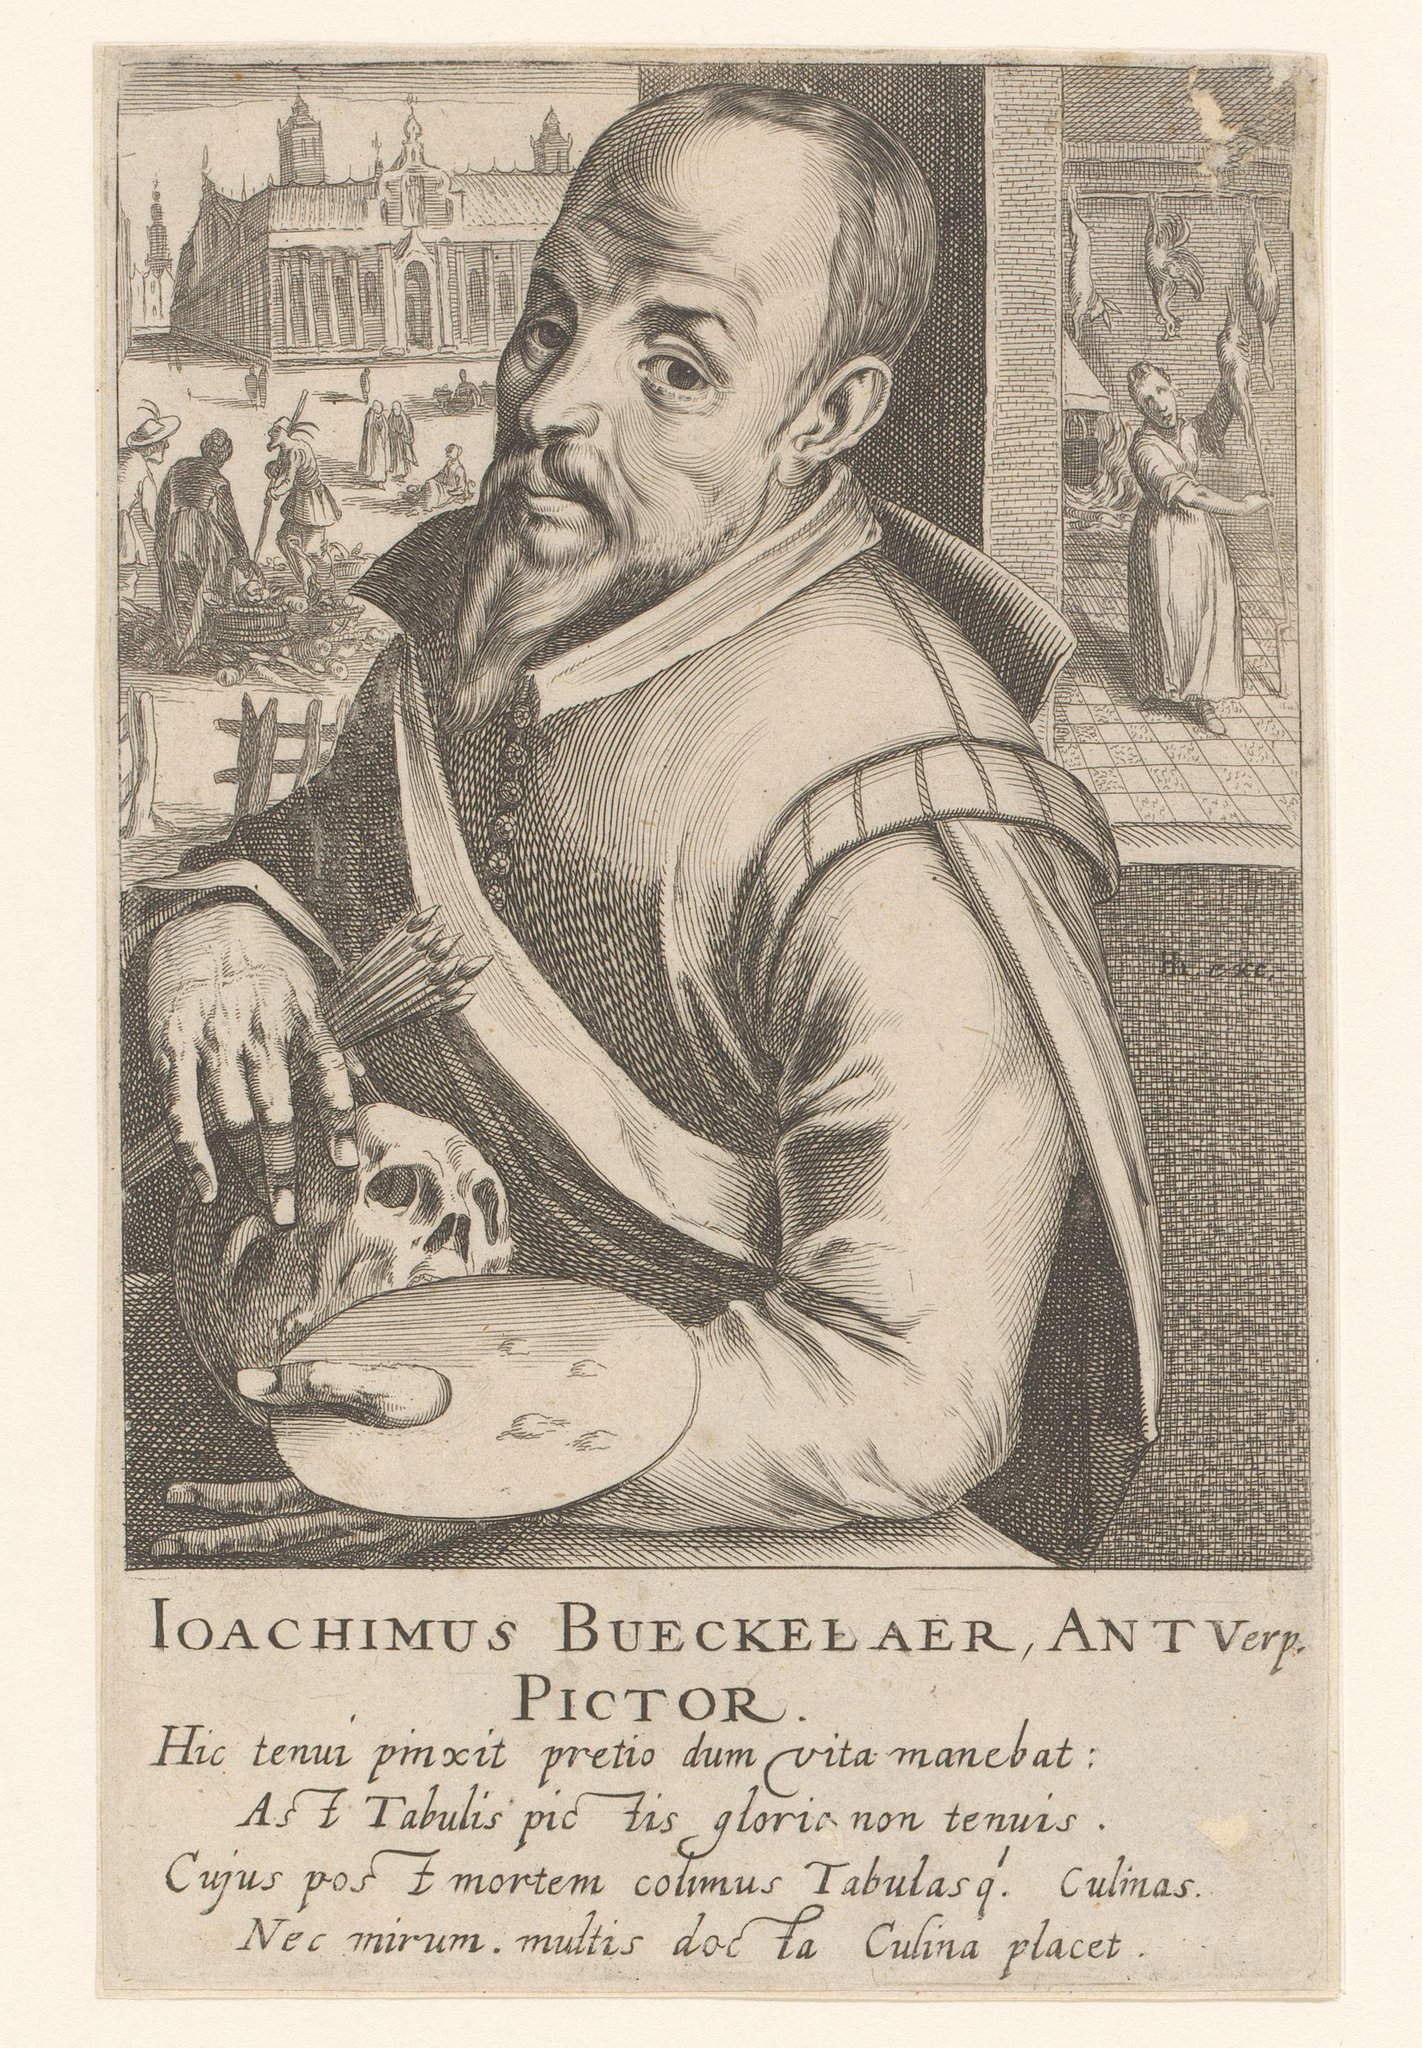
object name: print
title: Pictorum aliquot celebrium praecipuae Germaniae Inferioris effigies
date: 1610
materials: paper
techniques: engraving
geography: the hague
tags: antwerp, draughtsman, joachim bueckelaer, historical persons, portrait, self-portrait of painter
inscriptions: collector's mark: Lugt 2166, collector's mark: Lugt 2760